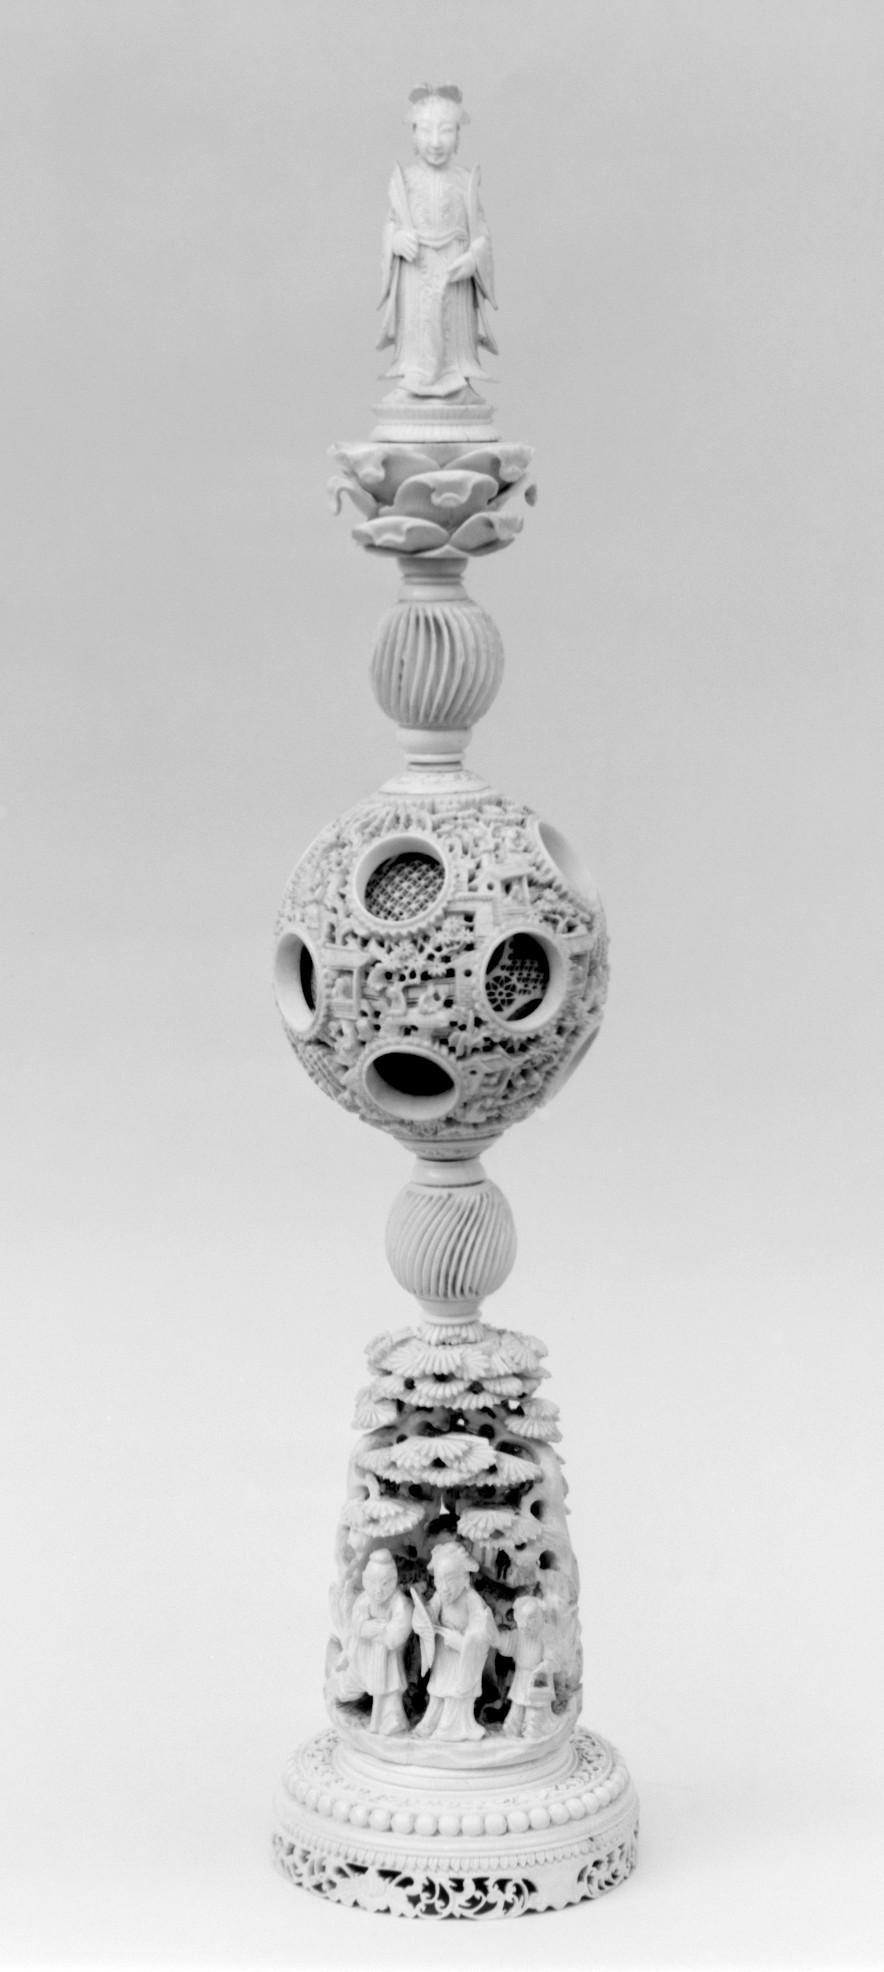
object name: chessman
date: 1867-1900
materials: ivory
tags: chess,games